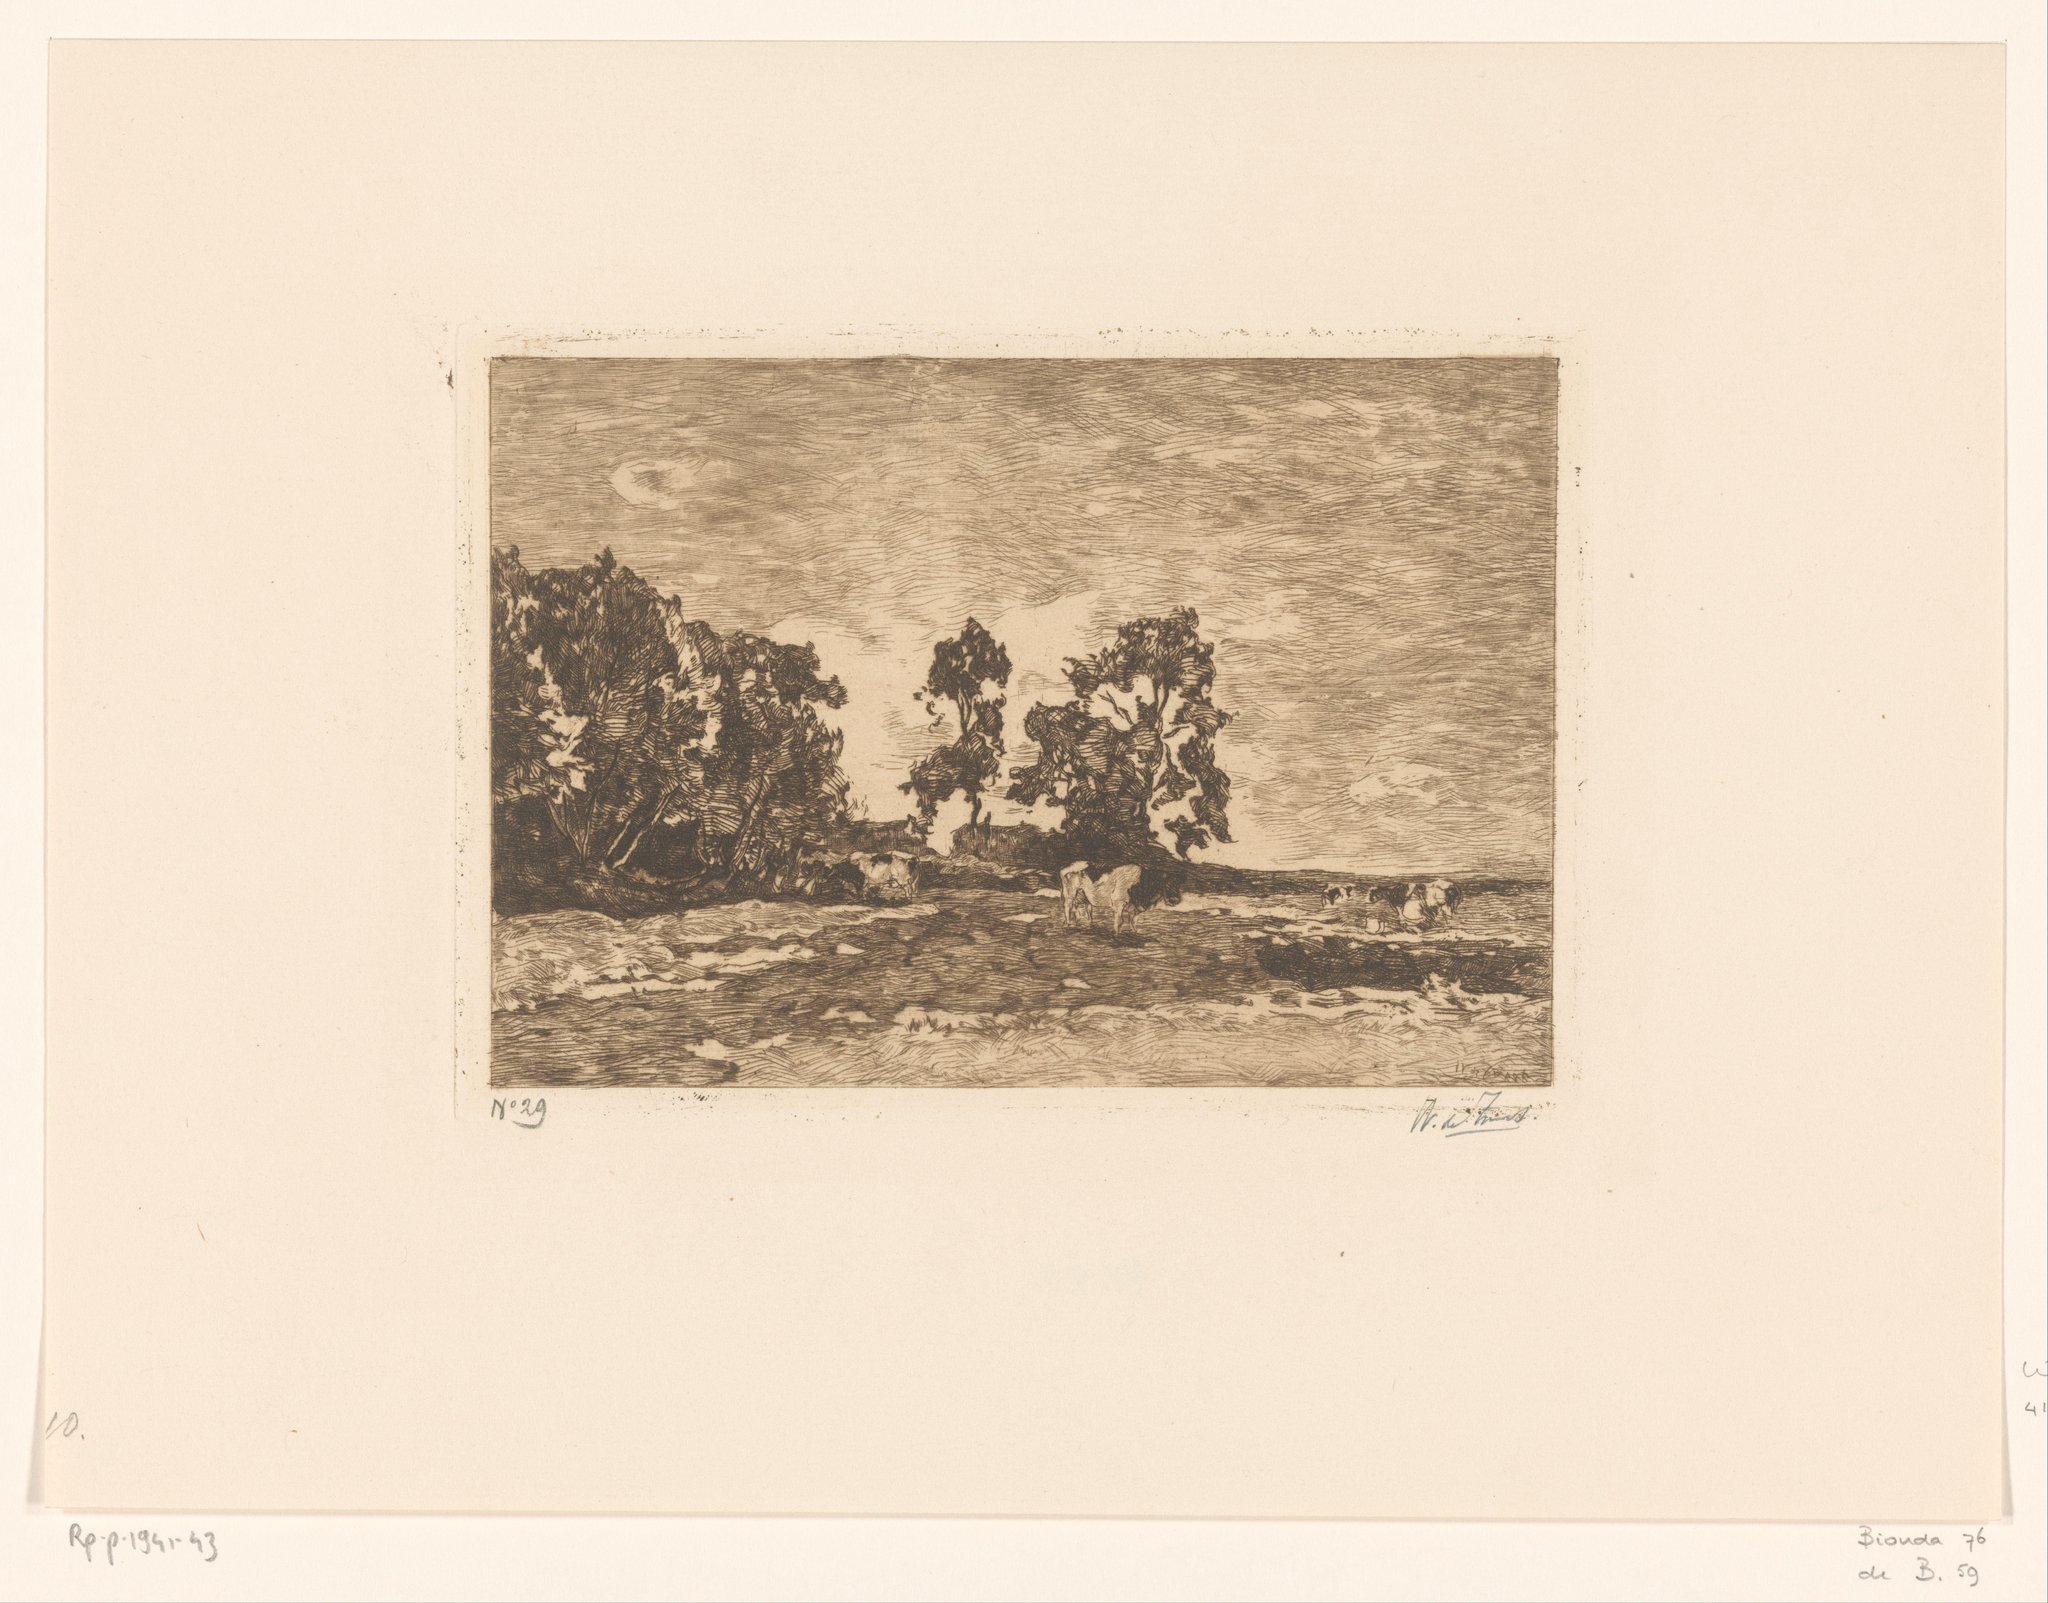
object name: print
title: Weide met koeien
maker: willem de zwart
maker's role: draughtsman, painter, print maker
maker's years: 1862-1931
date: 1896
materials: paper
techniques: drypoint, etching, intaglio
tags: cow, meadow, pasture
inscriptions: collector's mark: Lugt 2760, collector's mark: Lugt 2228